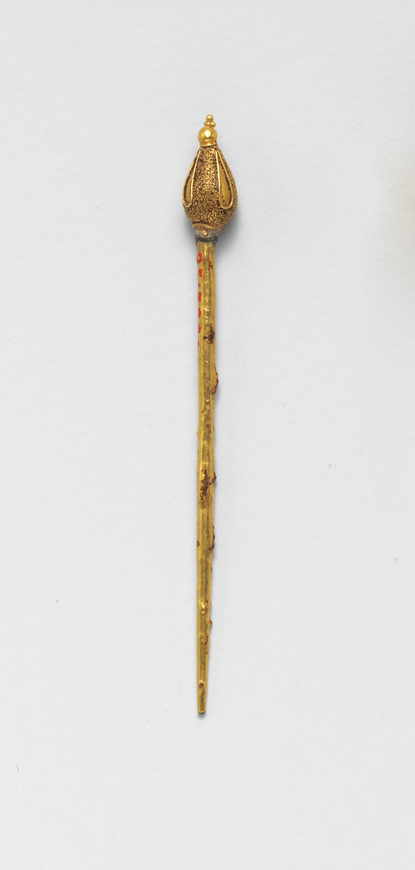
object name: pin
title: Gold pin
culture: etruscan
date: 534-401 BCE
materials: gold, iron